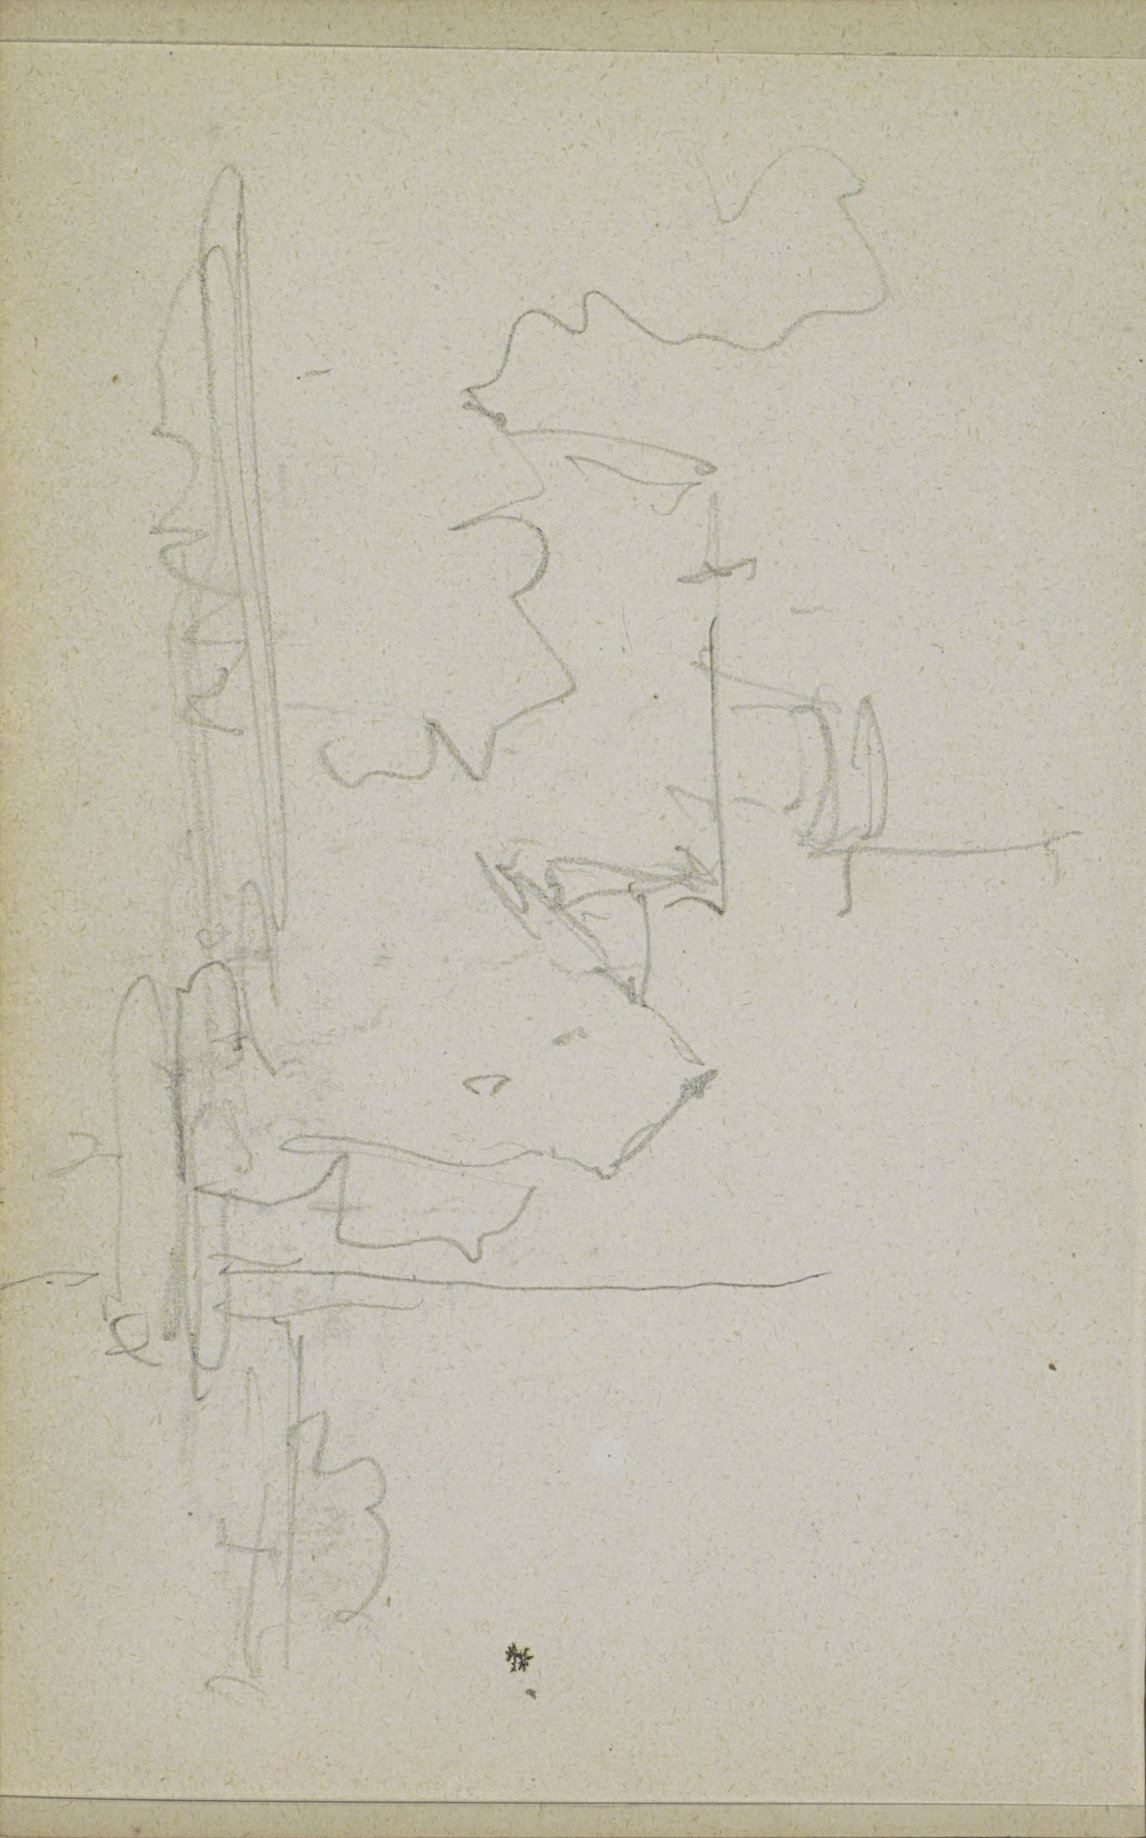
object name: sketchbook leaf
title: Molen aan het water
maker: adrianus eversen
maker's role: draughtsman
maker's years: 1818-1897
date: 1828-1897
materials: paper, pencil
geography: netherlands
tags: sailing-ship, sailing-boat, landscapes with waters, waterscapes, seascapes (in the temperate zone), windmill in landscape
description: Molen aan het water. Vooraan een zeilschip. Blad 30 verso uit een schetsboek met 58 bladen.